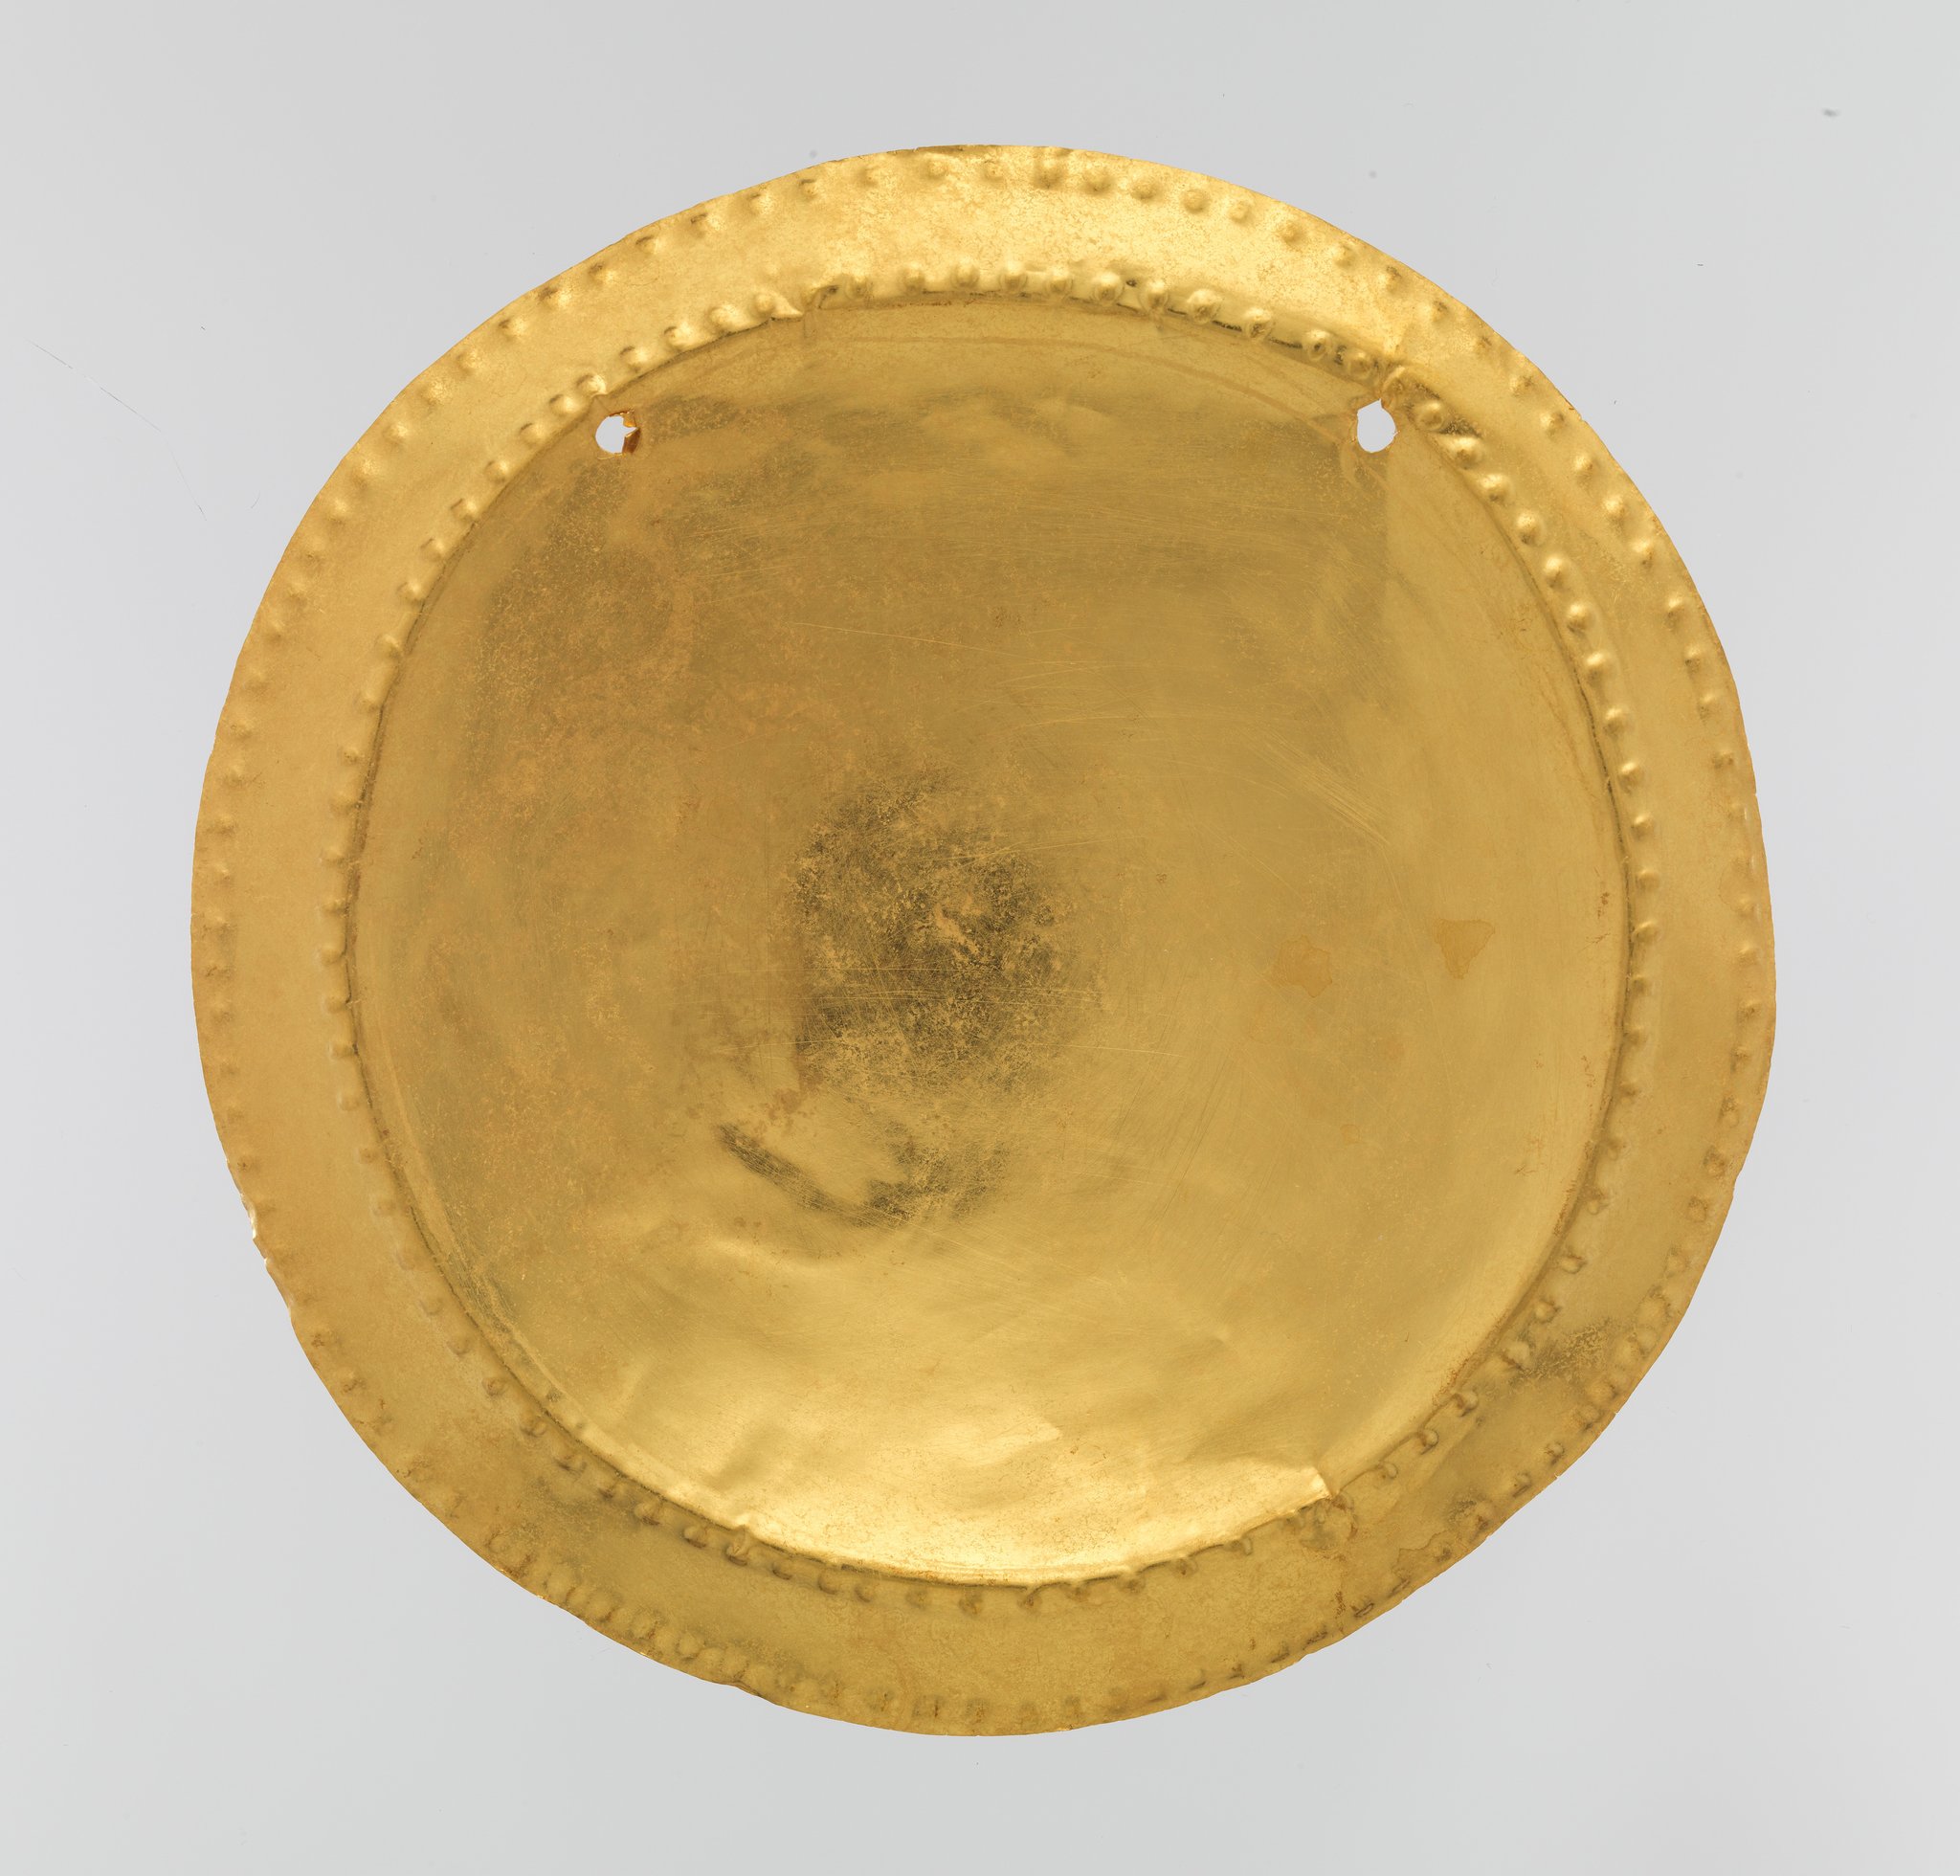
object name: pectoral disk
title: Pectoral Disk (Patena)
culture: coclé, macaracas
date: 701-1200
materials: gold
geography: panama